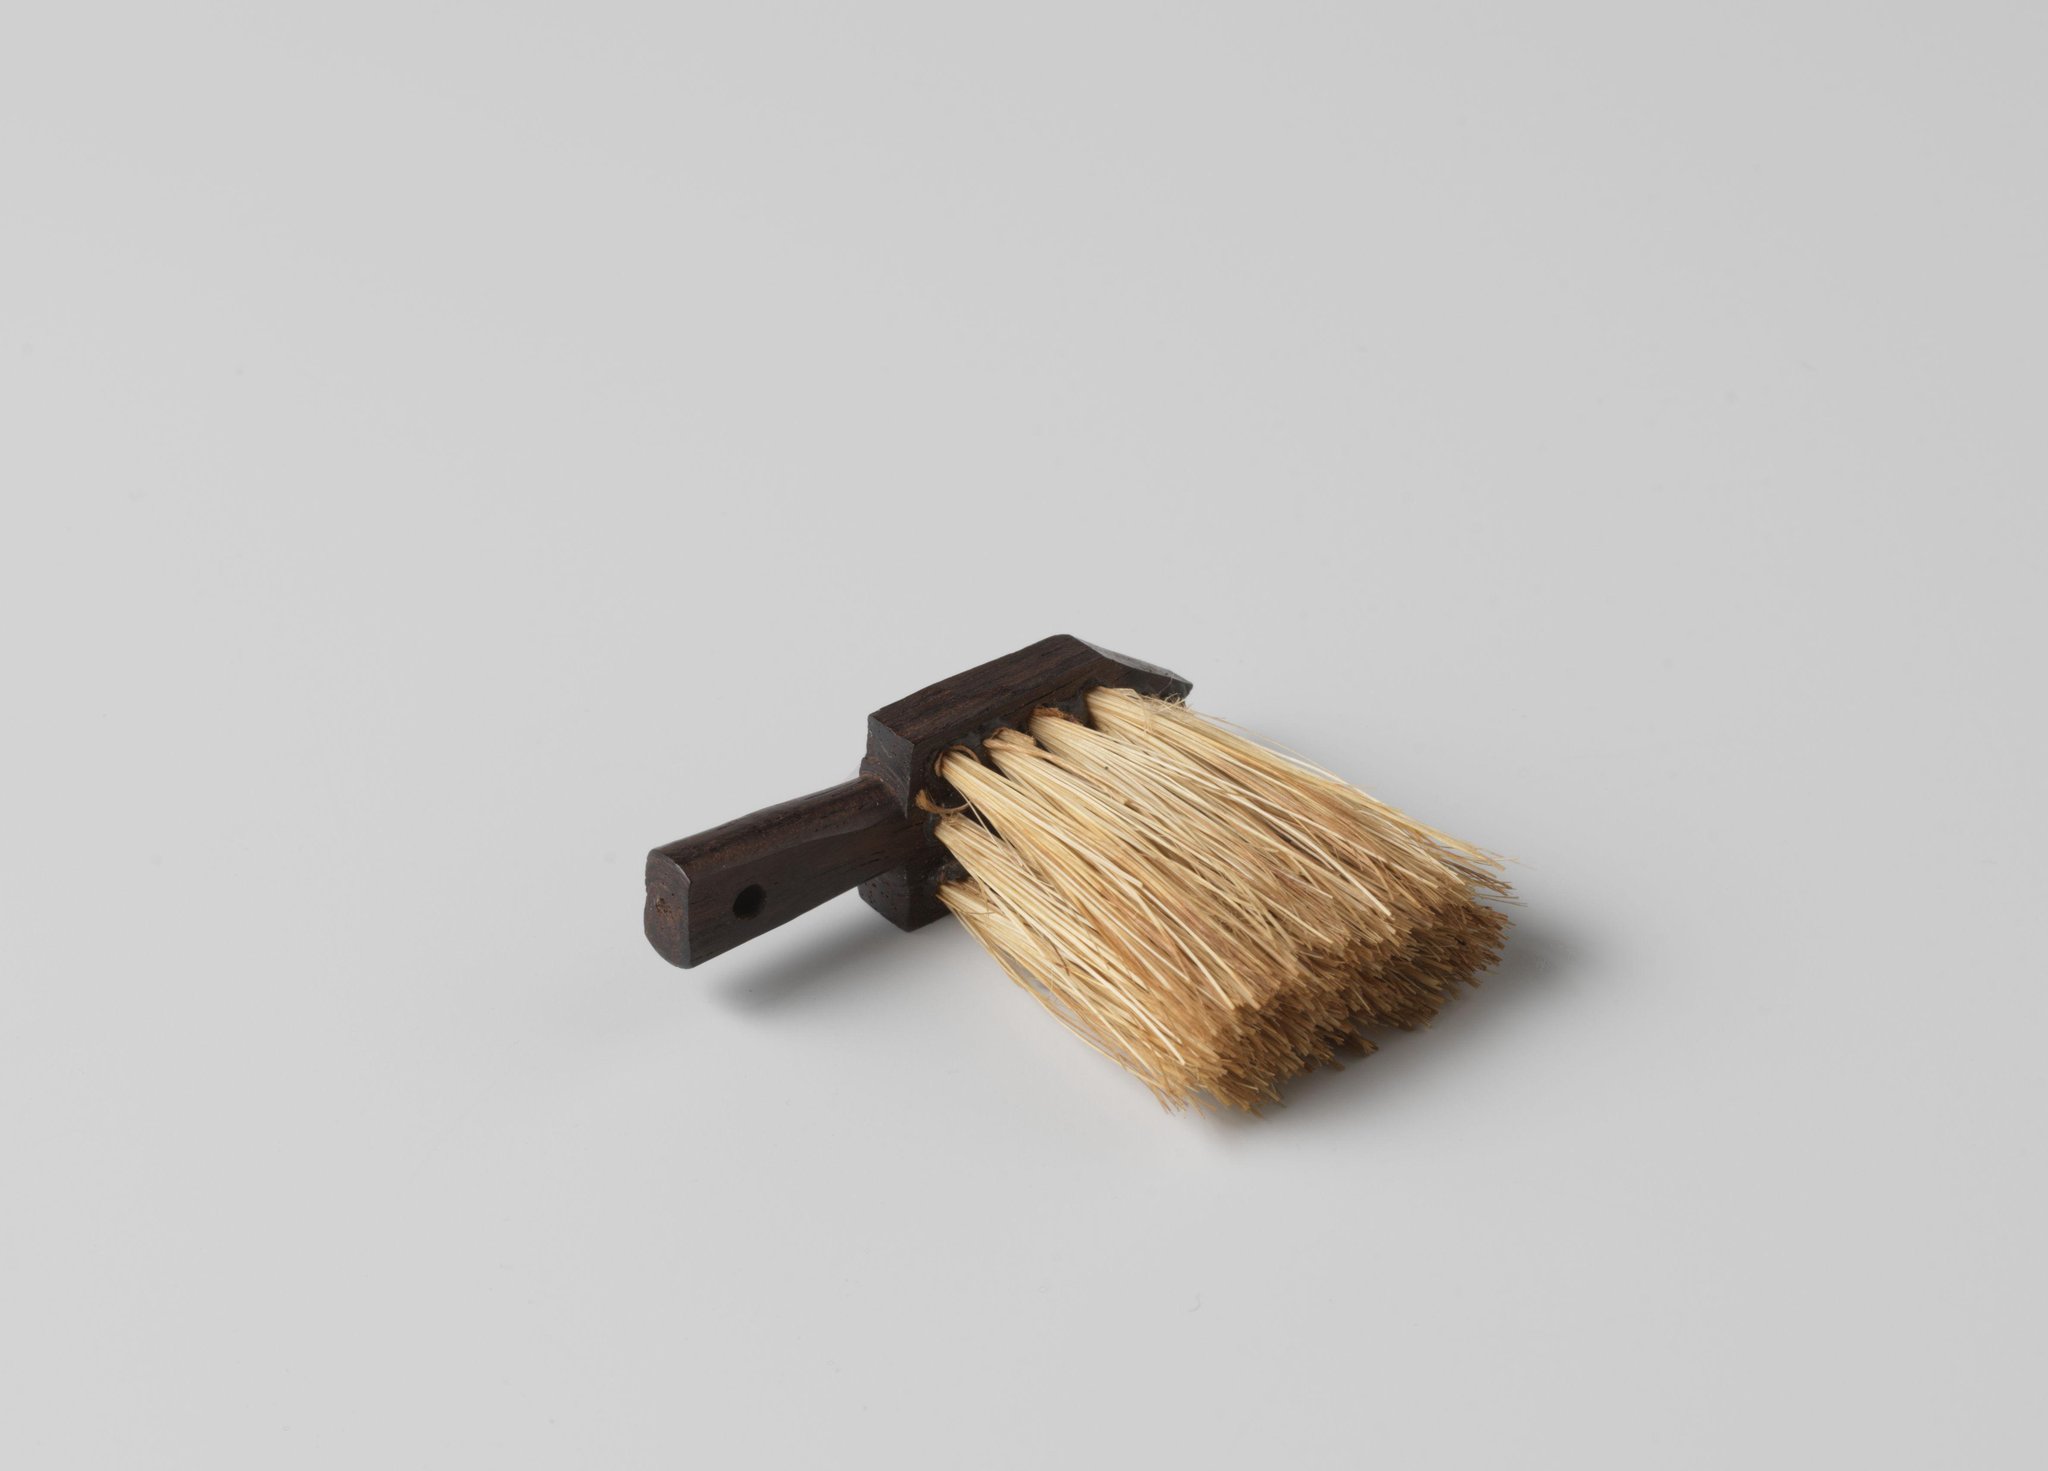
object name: whisk broom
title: Stoffer met puntig uitlopende rug en gladde steel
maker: Anonymous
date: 1675-1699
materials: wood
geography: amsterdam